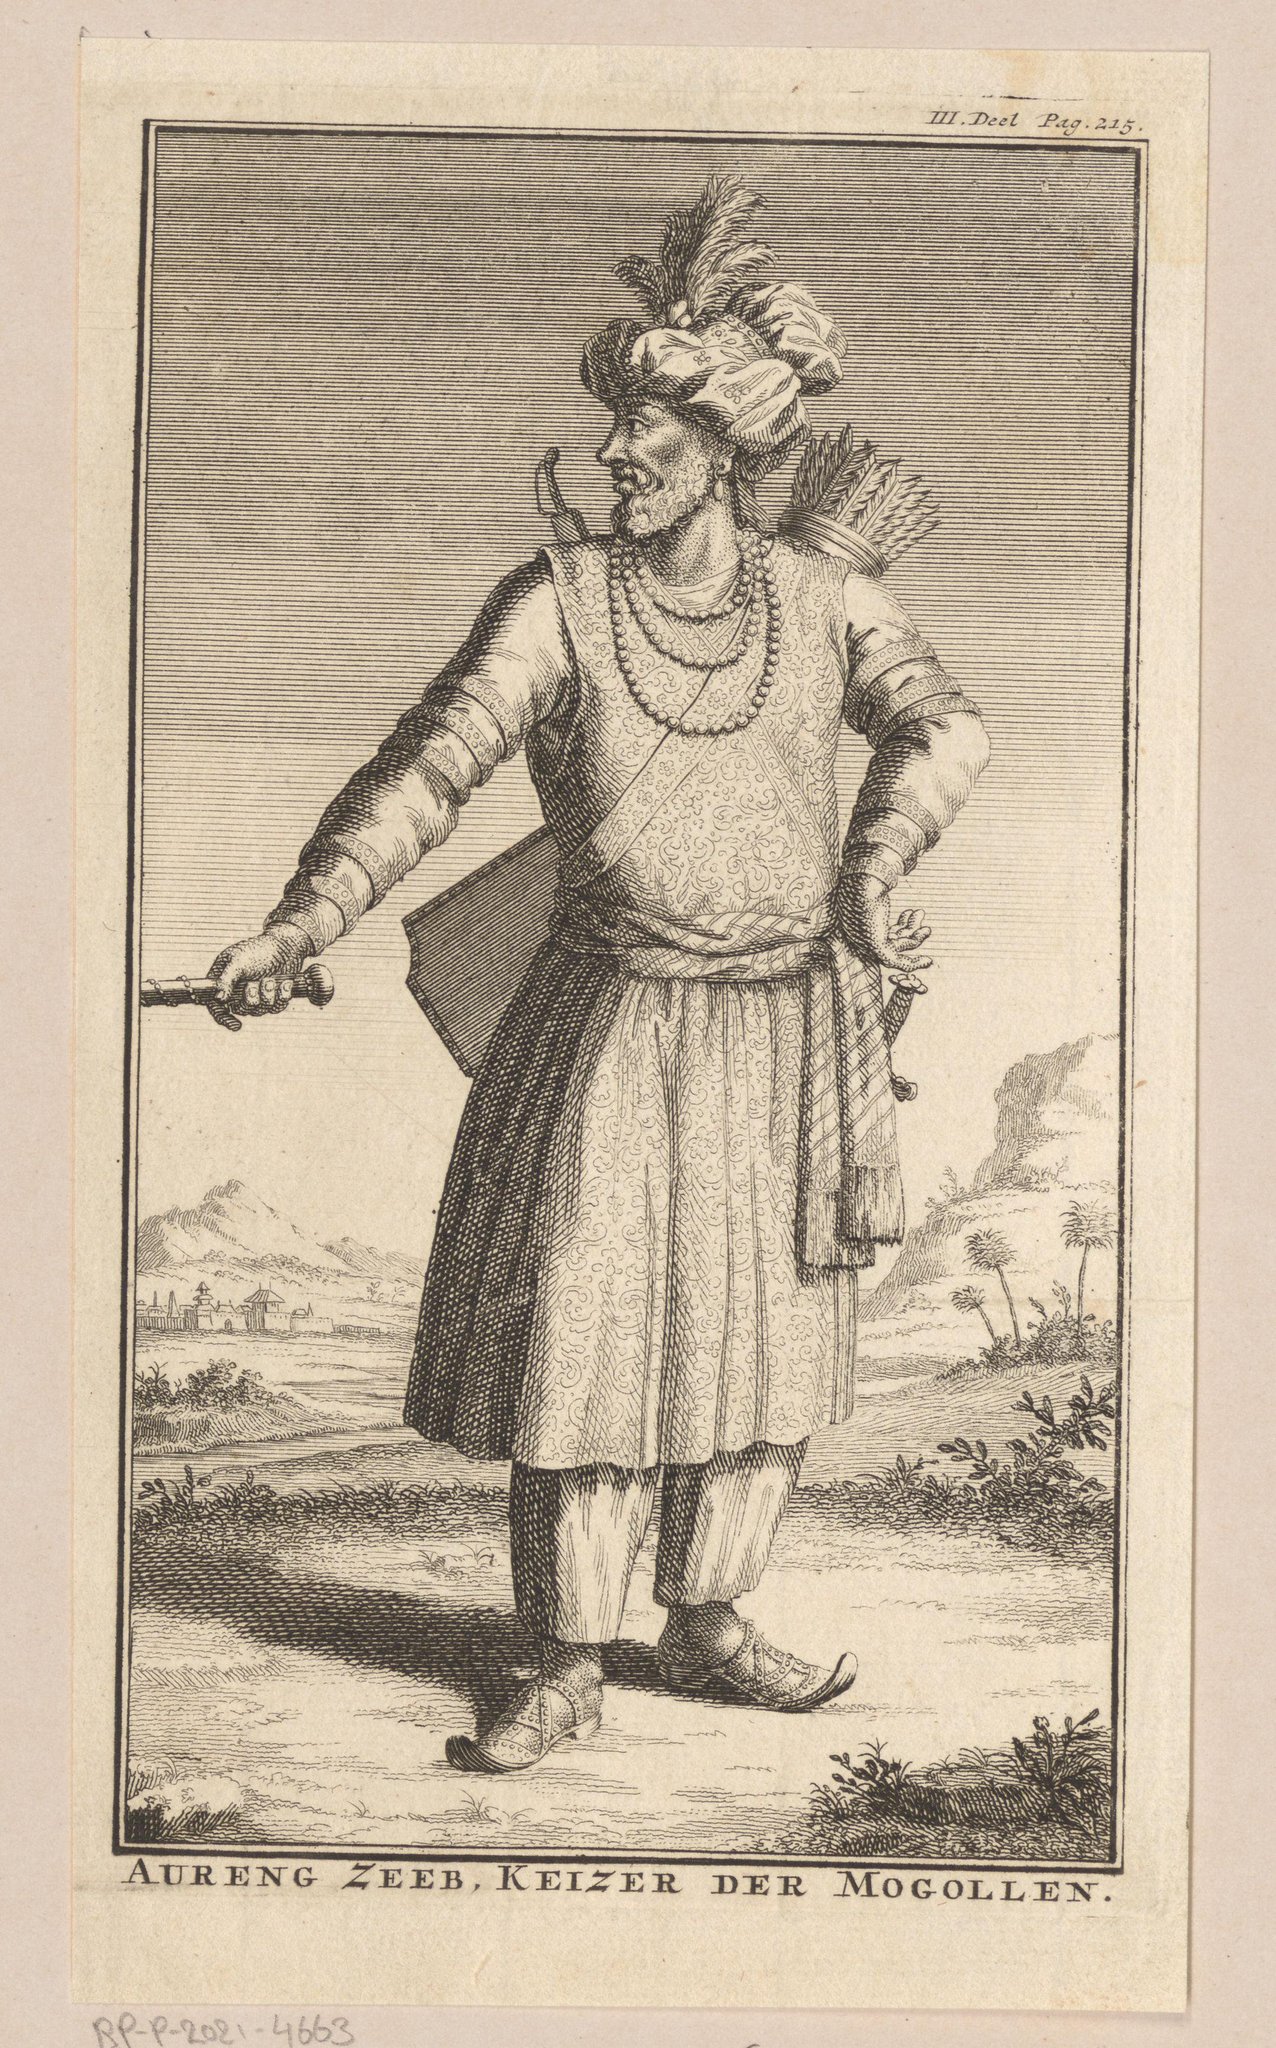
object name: print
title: Portret van Aurangzeb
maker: Anonymous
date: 1731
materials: paper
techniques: etching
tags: standing figure, historical persons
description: Prent mogelijk uit: Salmon Thomas. Hedendaegsche historie of tegenwoordige staet van alle volkeren (...). Amsterdam: Isaak Tirion, 1731.